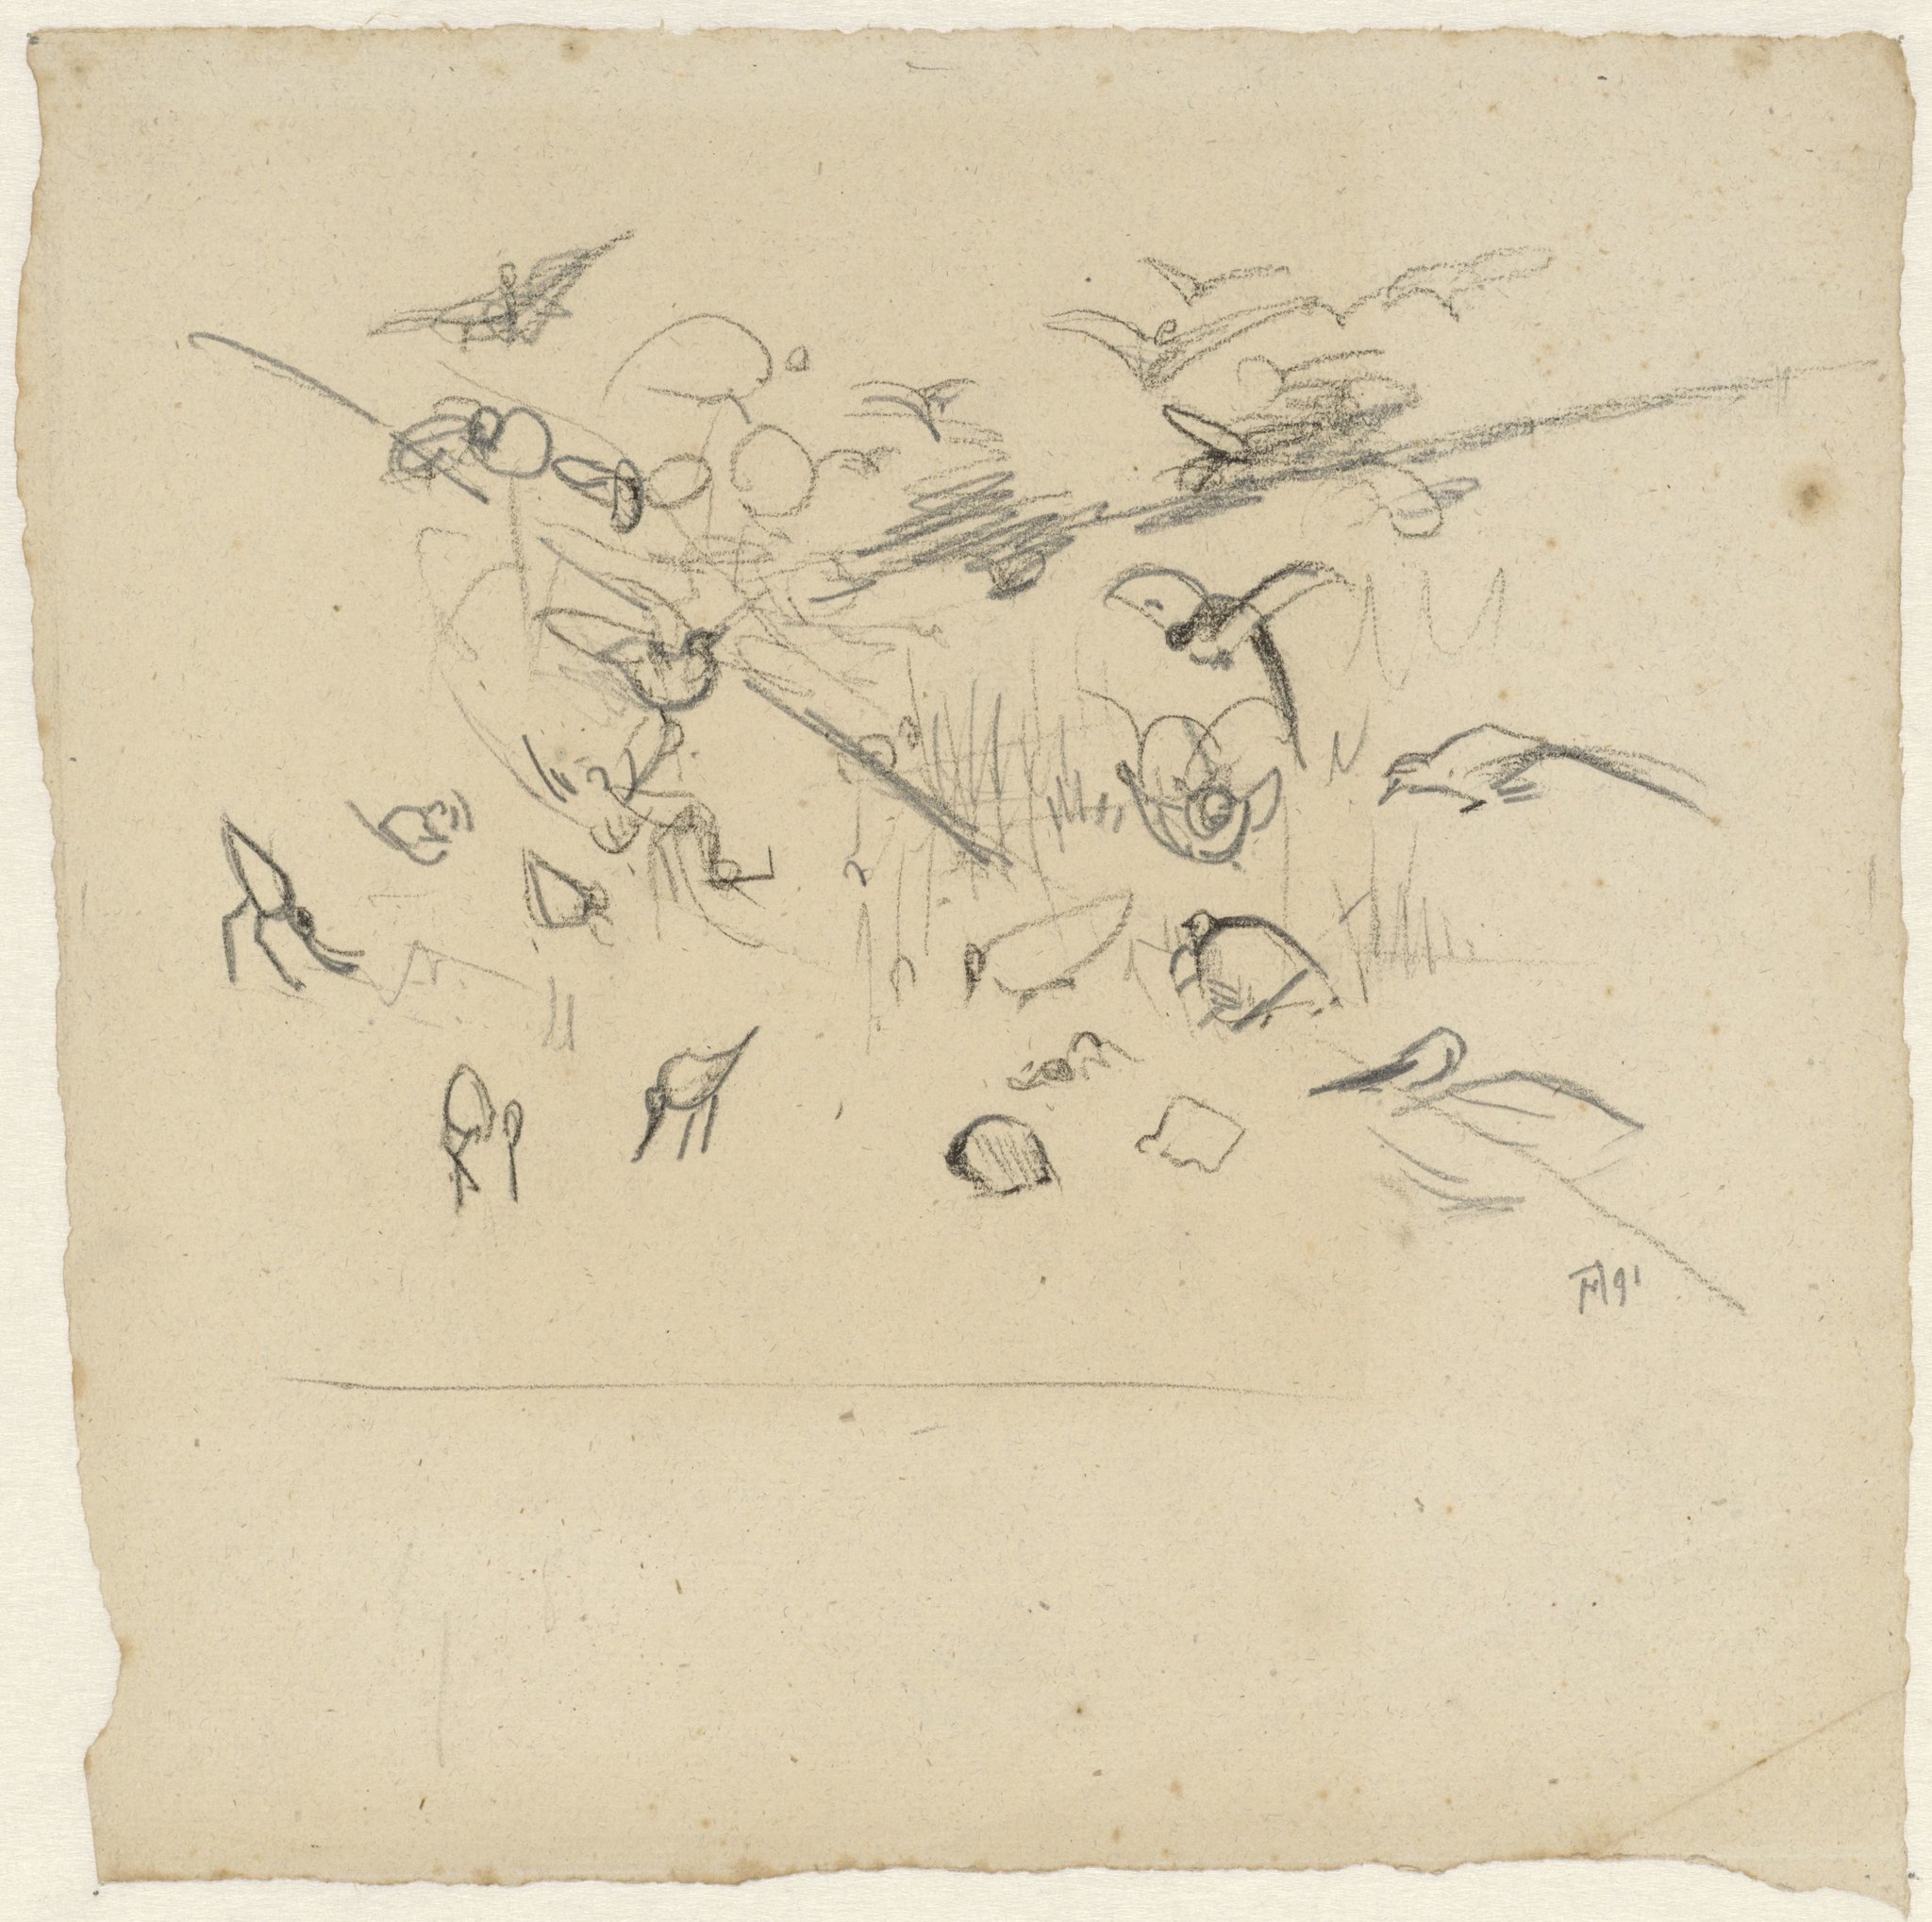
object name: drawing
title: Schets voor illustratie in Hoe de vogels aan een koning kwamen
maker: theo van hoytema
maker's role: draughtsman, painter, print maker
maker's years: 1863-1917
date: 1891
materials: chalk, paper, pencil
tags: birds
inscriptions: date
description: Voorstudie voor prent in 'Hoe de vogels aan een koning kwamen'.